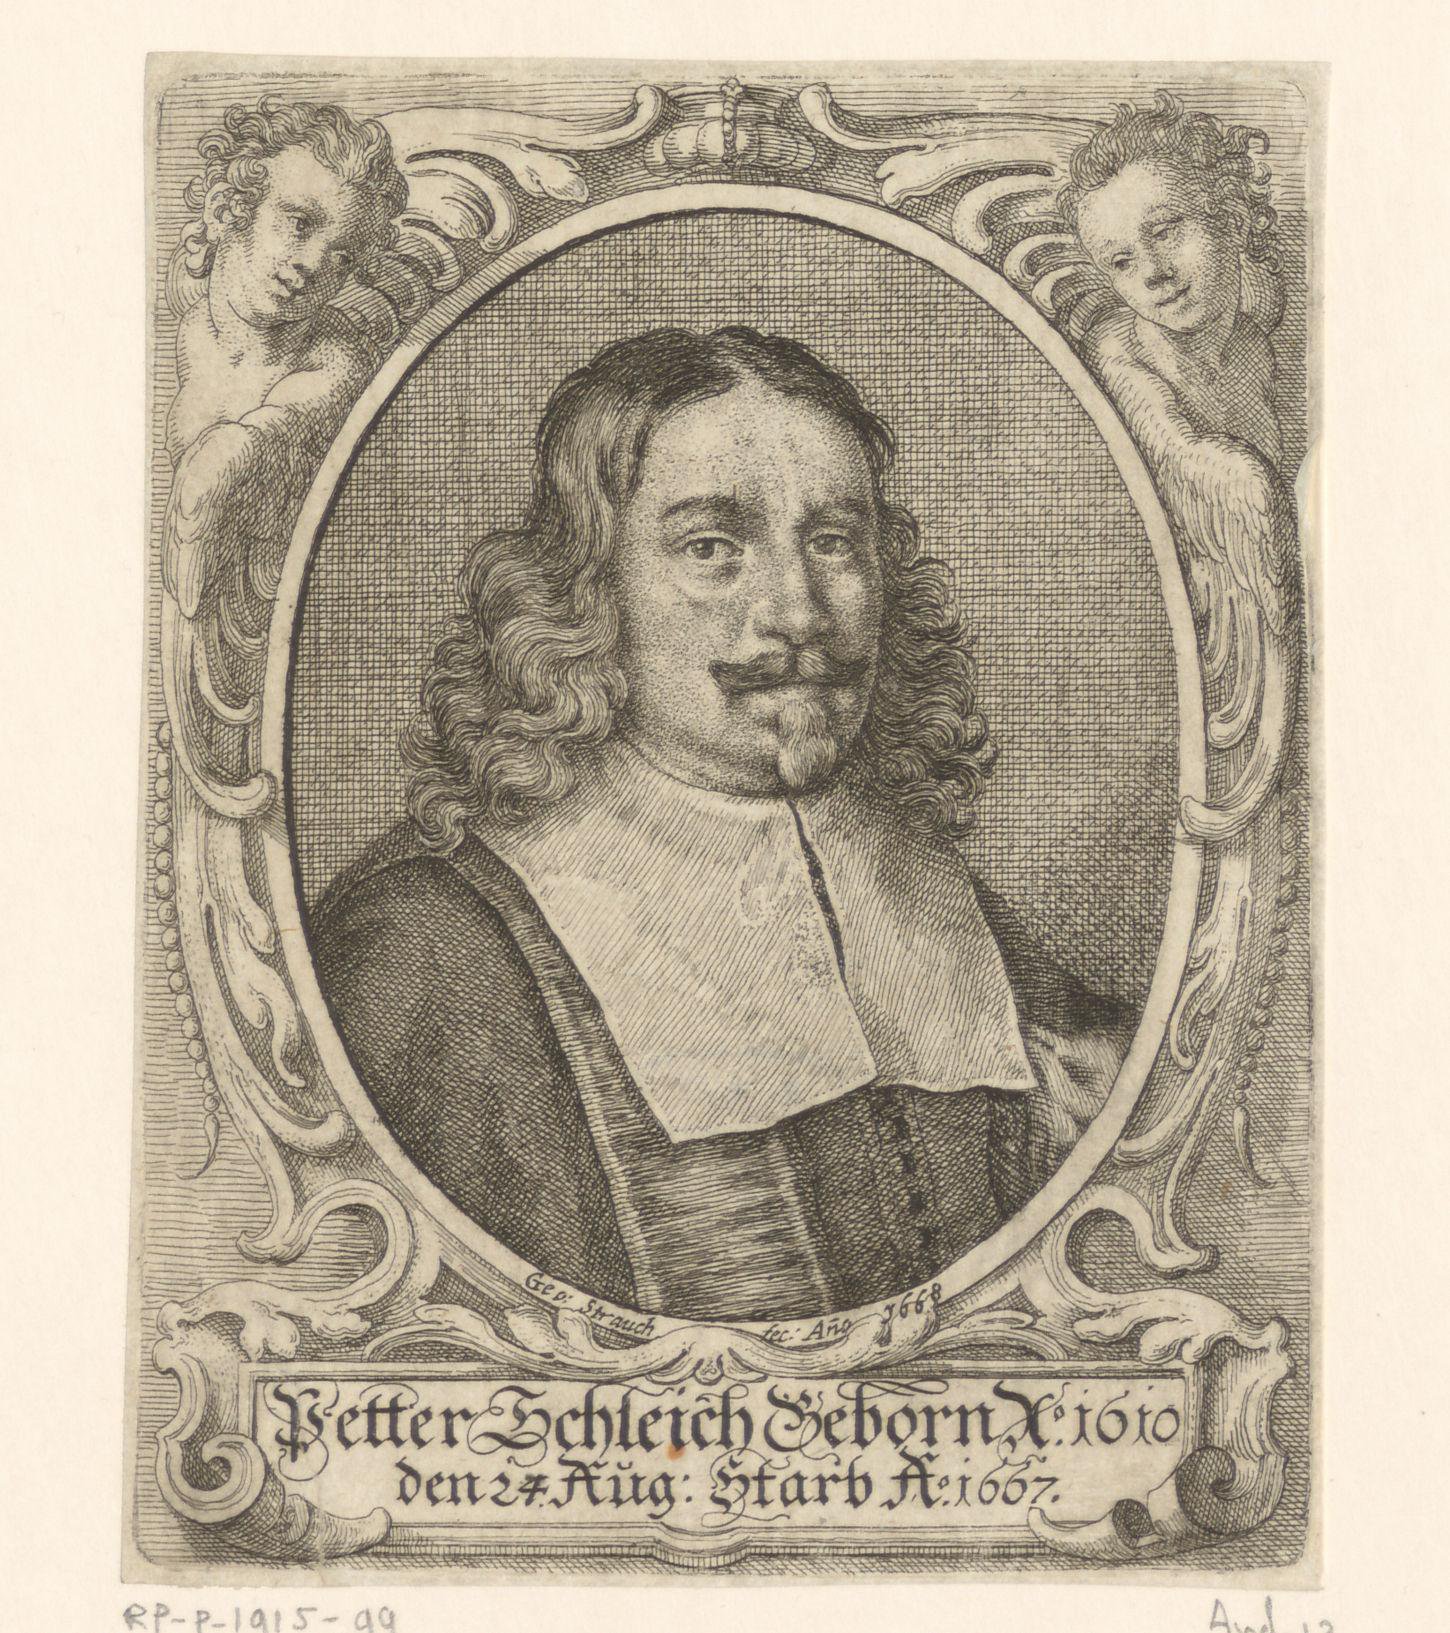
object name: print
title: Portret van Peter Schleich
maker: georg strauch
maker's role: print maker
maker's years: 1613-1675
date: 1668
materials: paper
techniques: etching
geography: nuremberg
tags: goldsmith, historical persons, angels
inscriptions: collector's mark: Lugt 2228